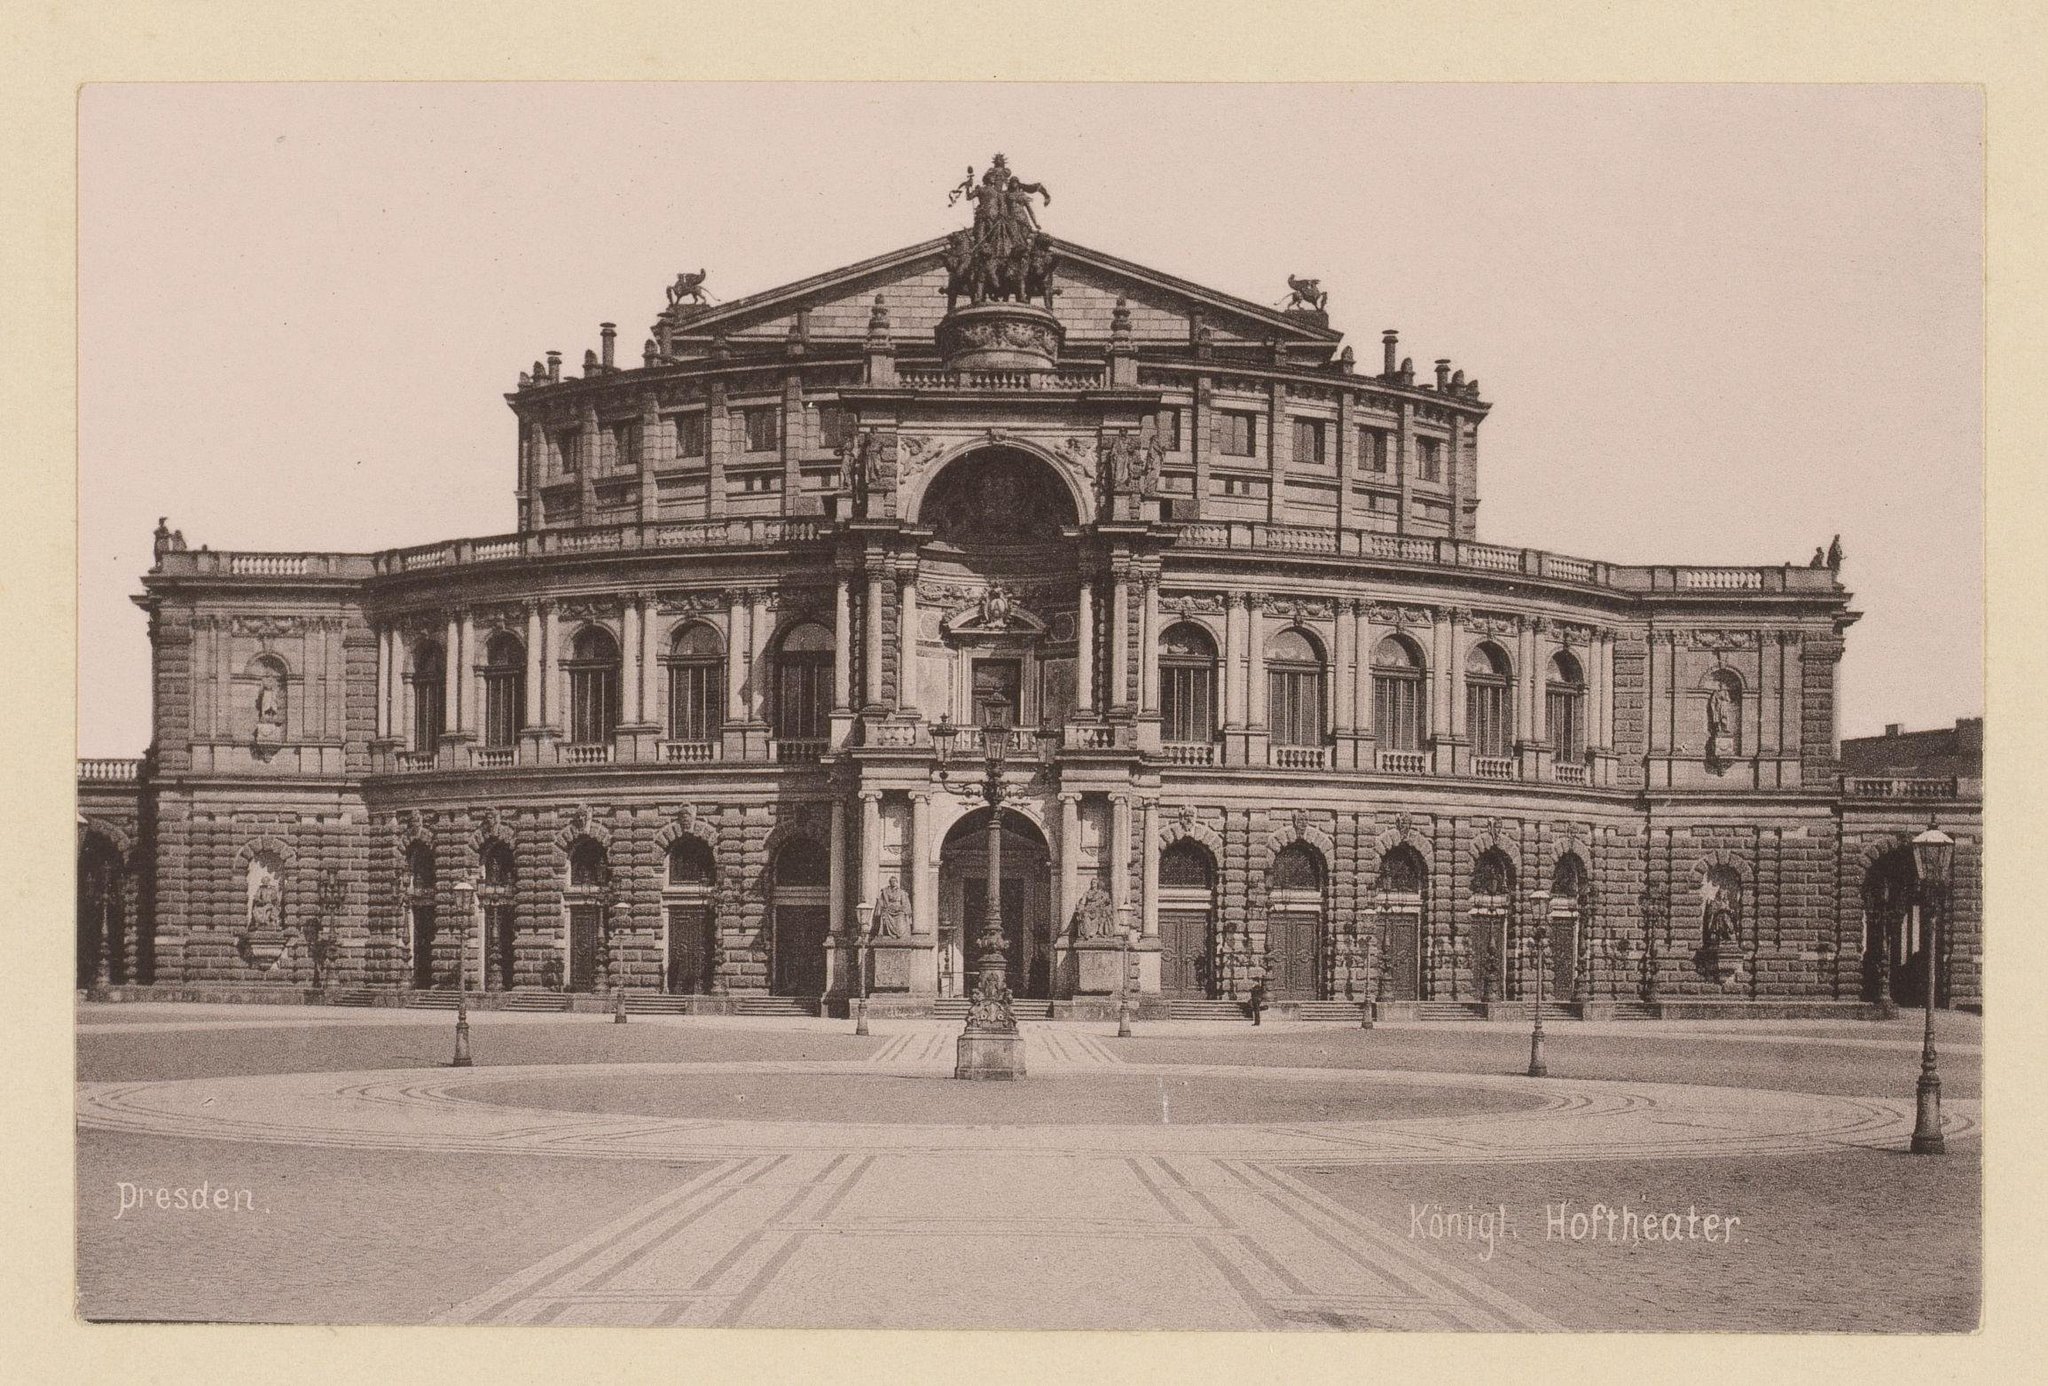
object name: photomechanical print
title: Dresden. Königl. Hoftheater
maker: Anonymous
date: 1880-1895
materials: cardboard, paper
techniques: photograph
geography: dresden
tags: opera house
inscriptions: inscription: ‘Dresden’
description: Deze prent zat oorspronkelijk in prentenkabinet RP-F-AA3192.